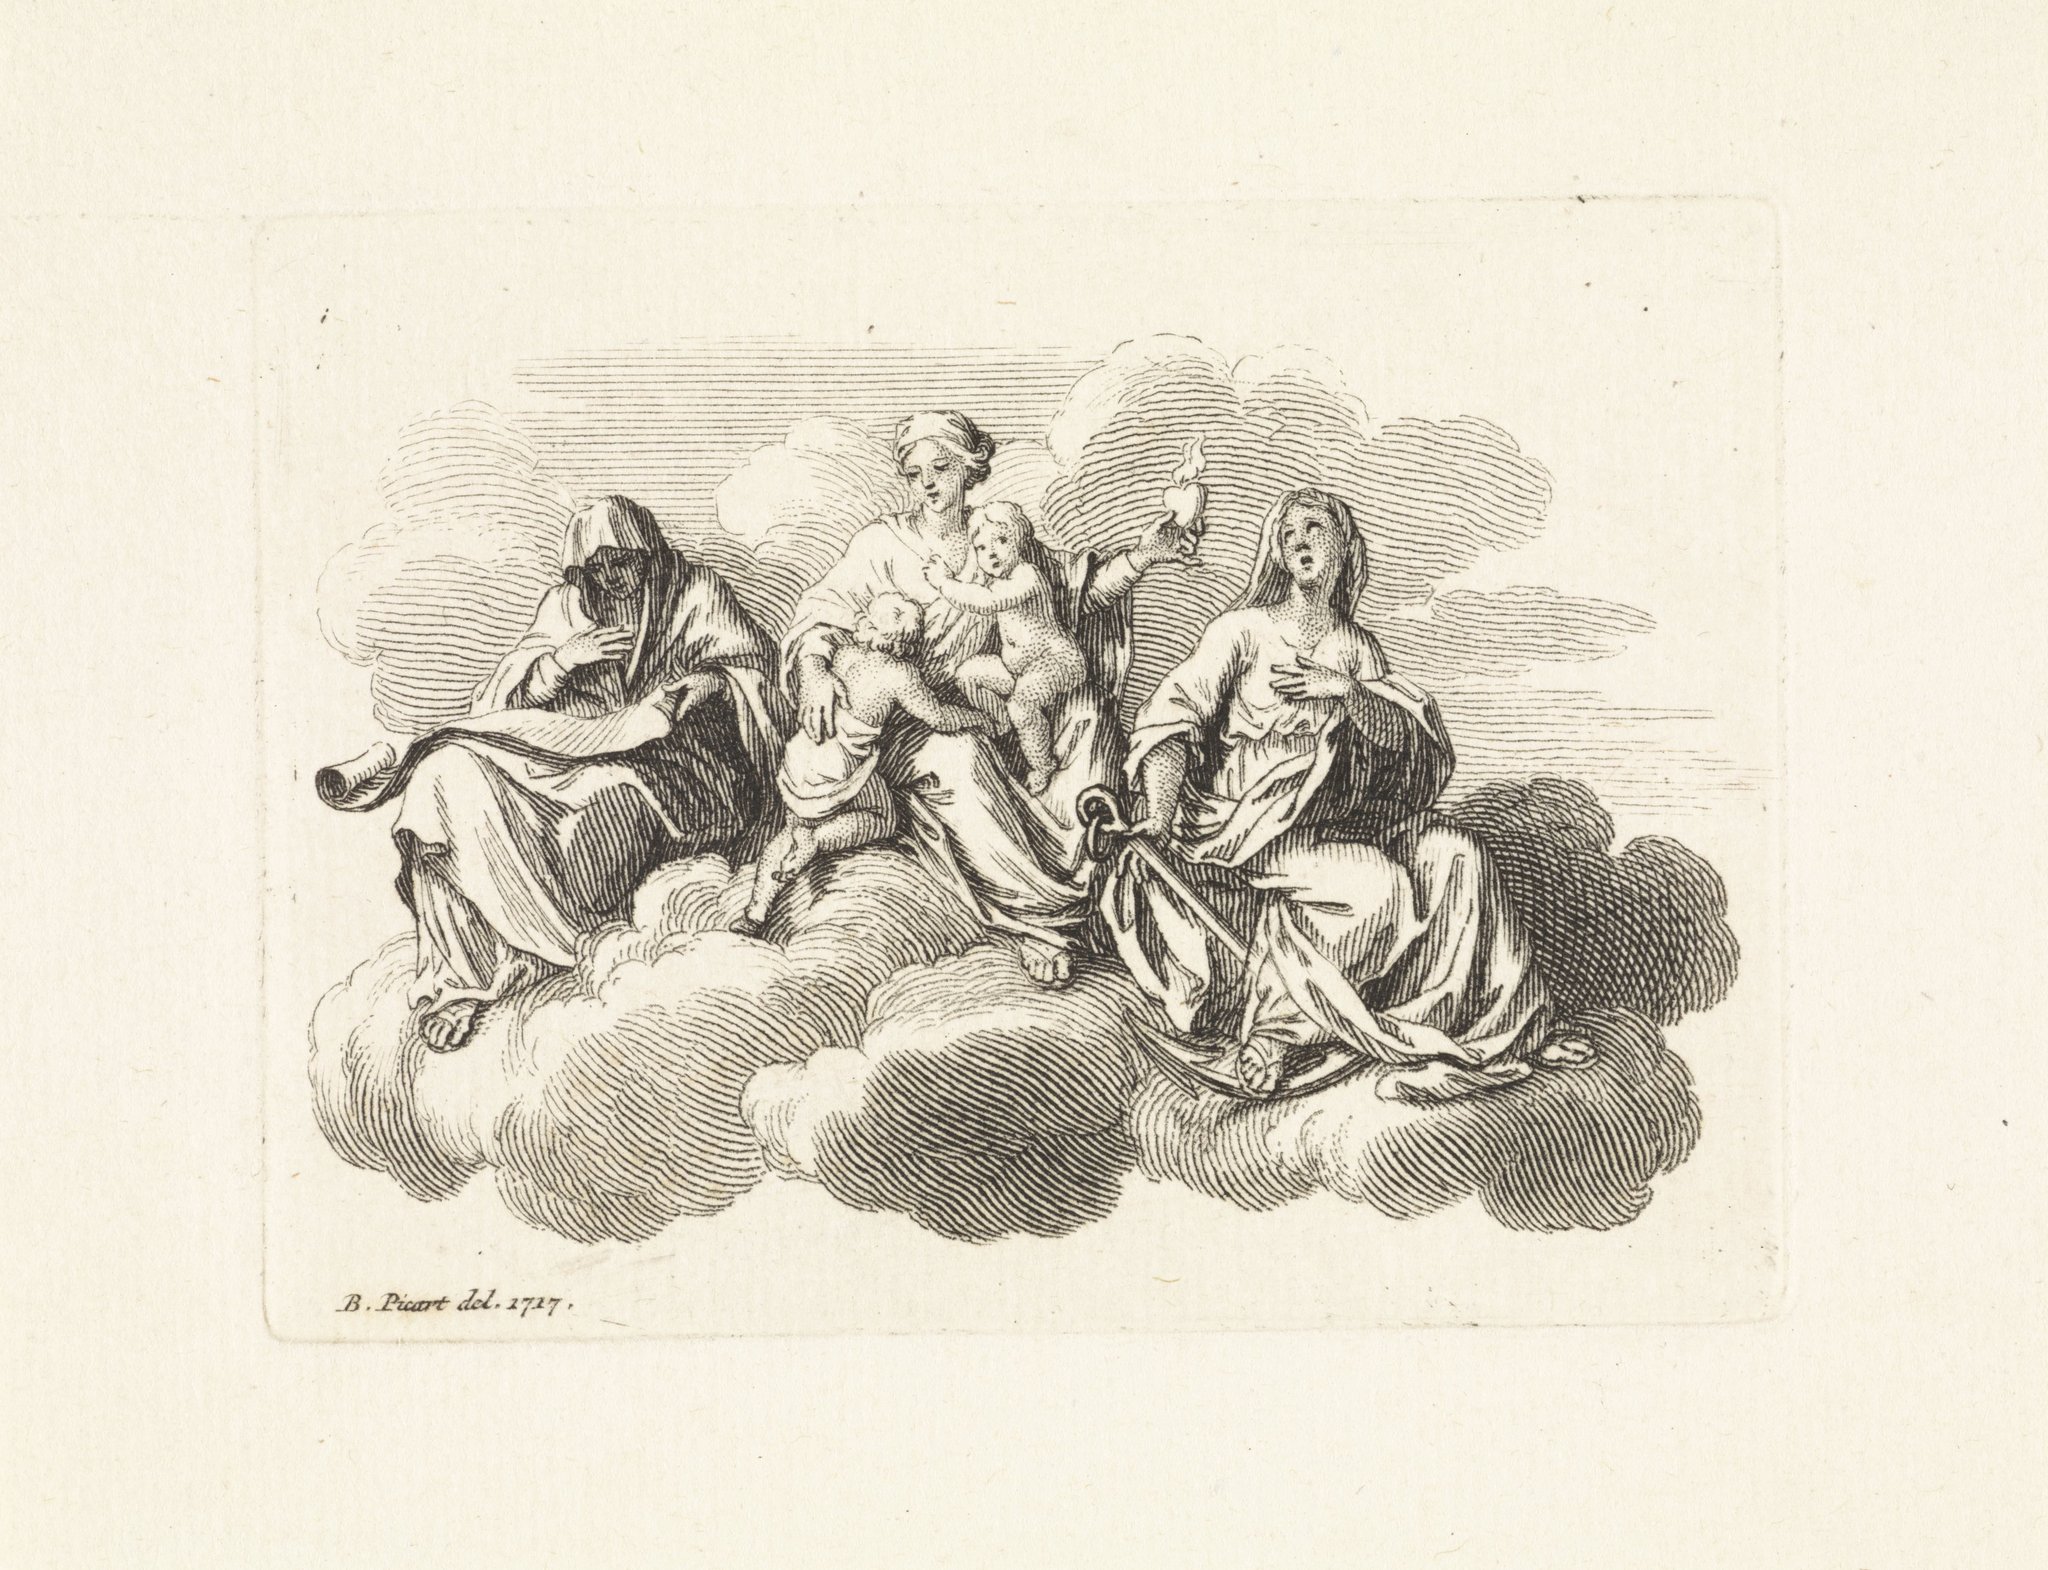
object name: print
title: Geloof, Liefde en Hoop op de wolken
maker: bernard picart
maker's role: draughtsman, print maker, publisher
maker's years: 1673-1733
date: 1717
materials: paper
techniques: engraving, etching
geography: amsterdam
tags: the three theological virtues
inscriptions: collector's mark: Lugt 2228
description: De drie theologische deugden Geloof, Liefde en Hoop zitten op de wolken.